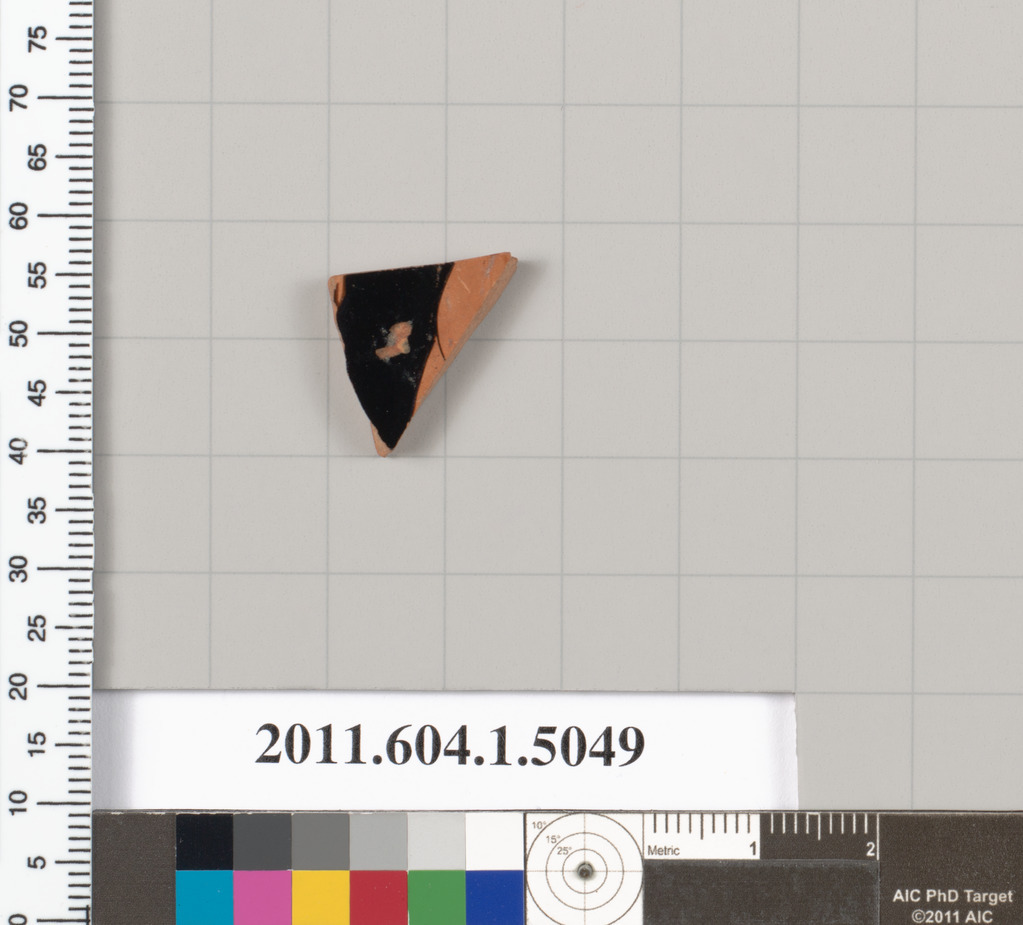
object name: kylix fragment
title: Terracotta fragment of a kylix (drinking cup)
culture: greek, attic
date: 475-451 BCE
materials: terracotta